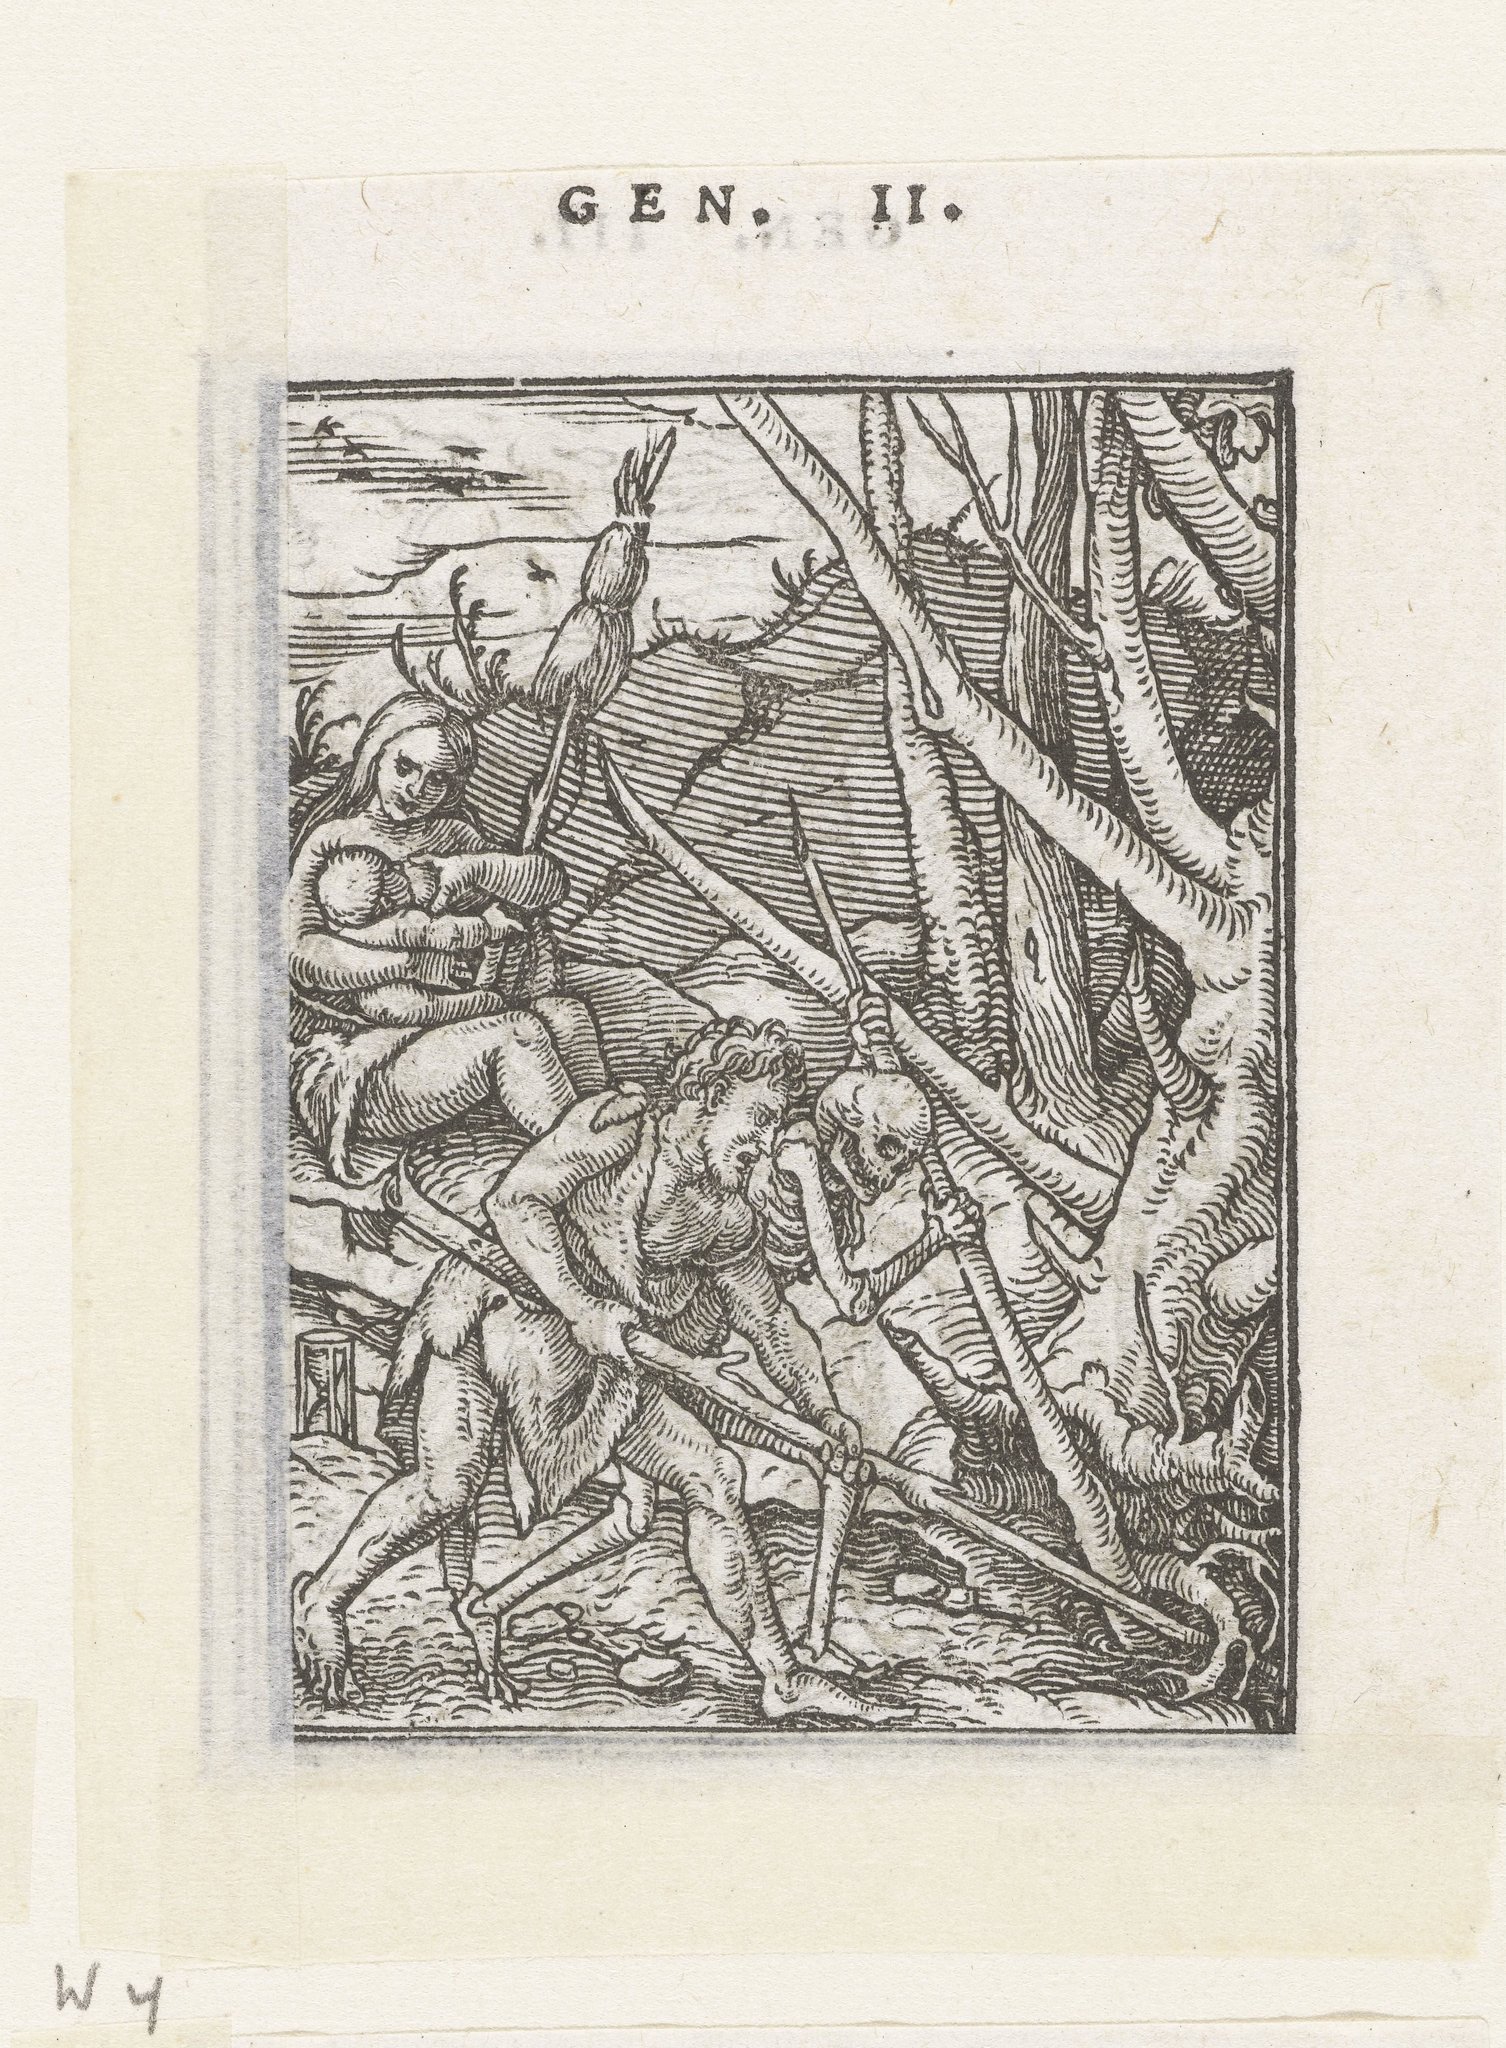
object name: print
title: Adam en Eva aan het werk na de zondeval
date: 1524-1526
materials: paper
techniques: woodcut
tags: adam engaged in agricultural activities, eve suckling the children, dance of death; death together with one or more human beings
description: De houtblokken werden voor 1526 vervaardigd door Hans Lützelburg en pas in 1538 voor het eerst gebruikt als boekillustraties in: Les simulachres & historiees faces de la mort avtant elegamment pourtraictes que artificiellement imaginées... a Lyon, Soubsz l'escu de Coloigne, MDXXXVIII, (M. en G. Trechsel, voor F. Frellon in Lyon), 1538. Later verschenen nog andere uitgaven.